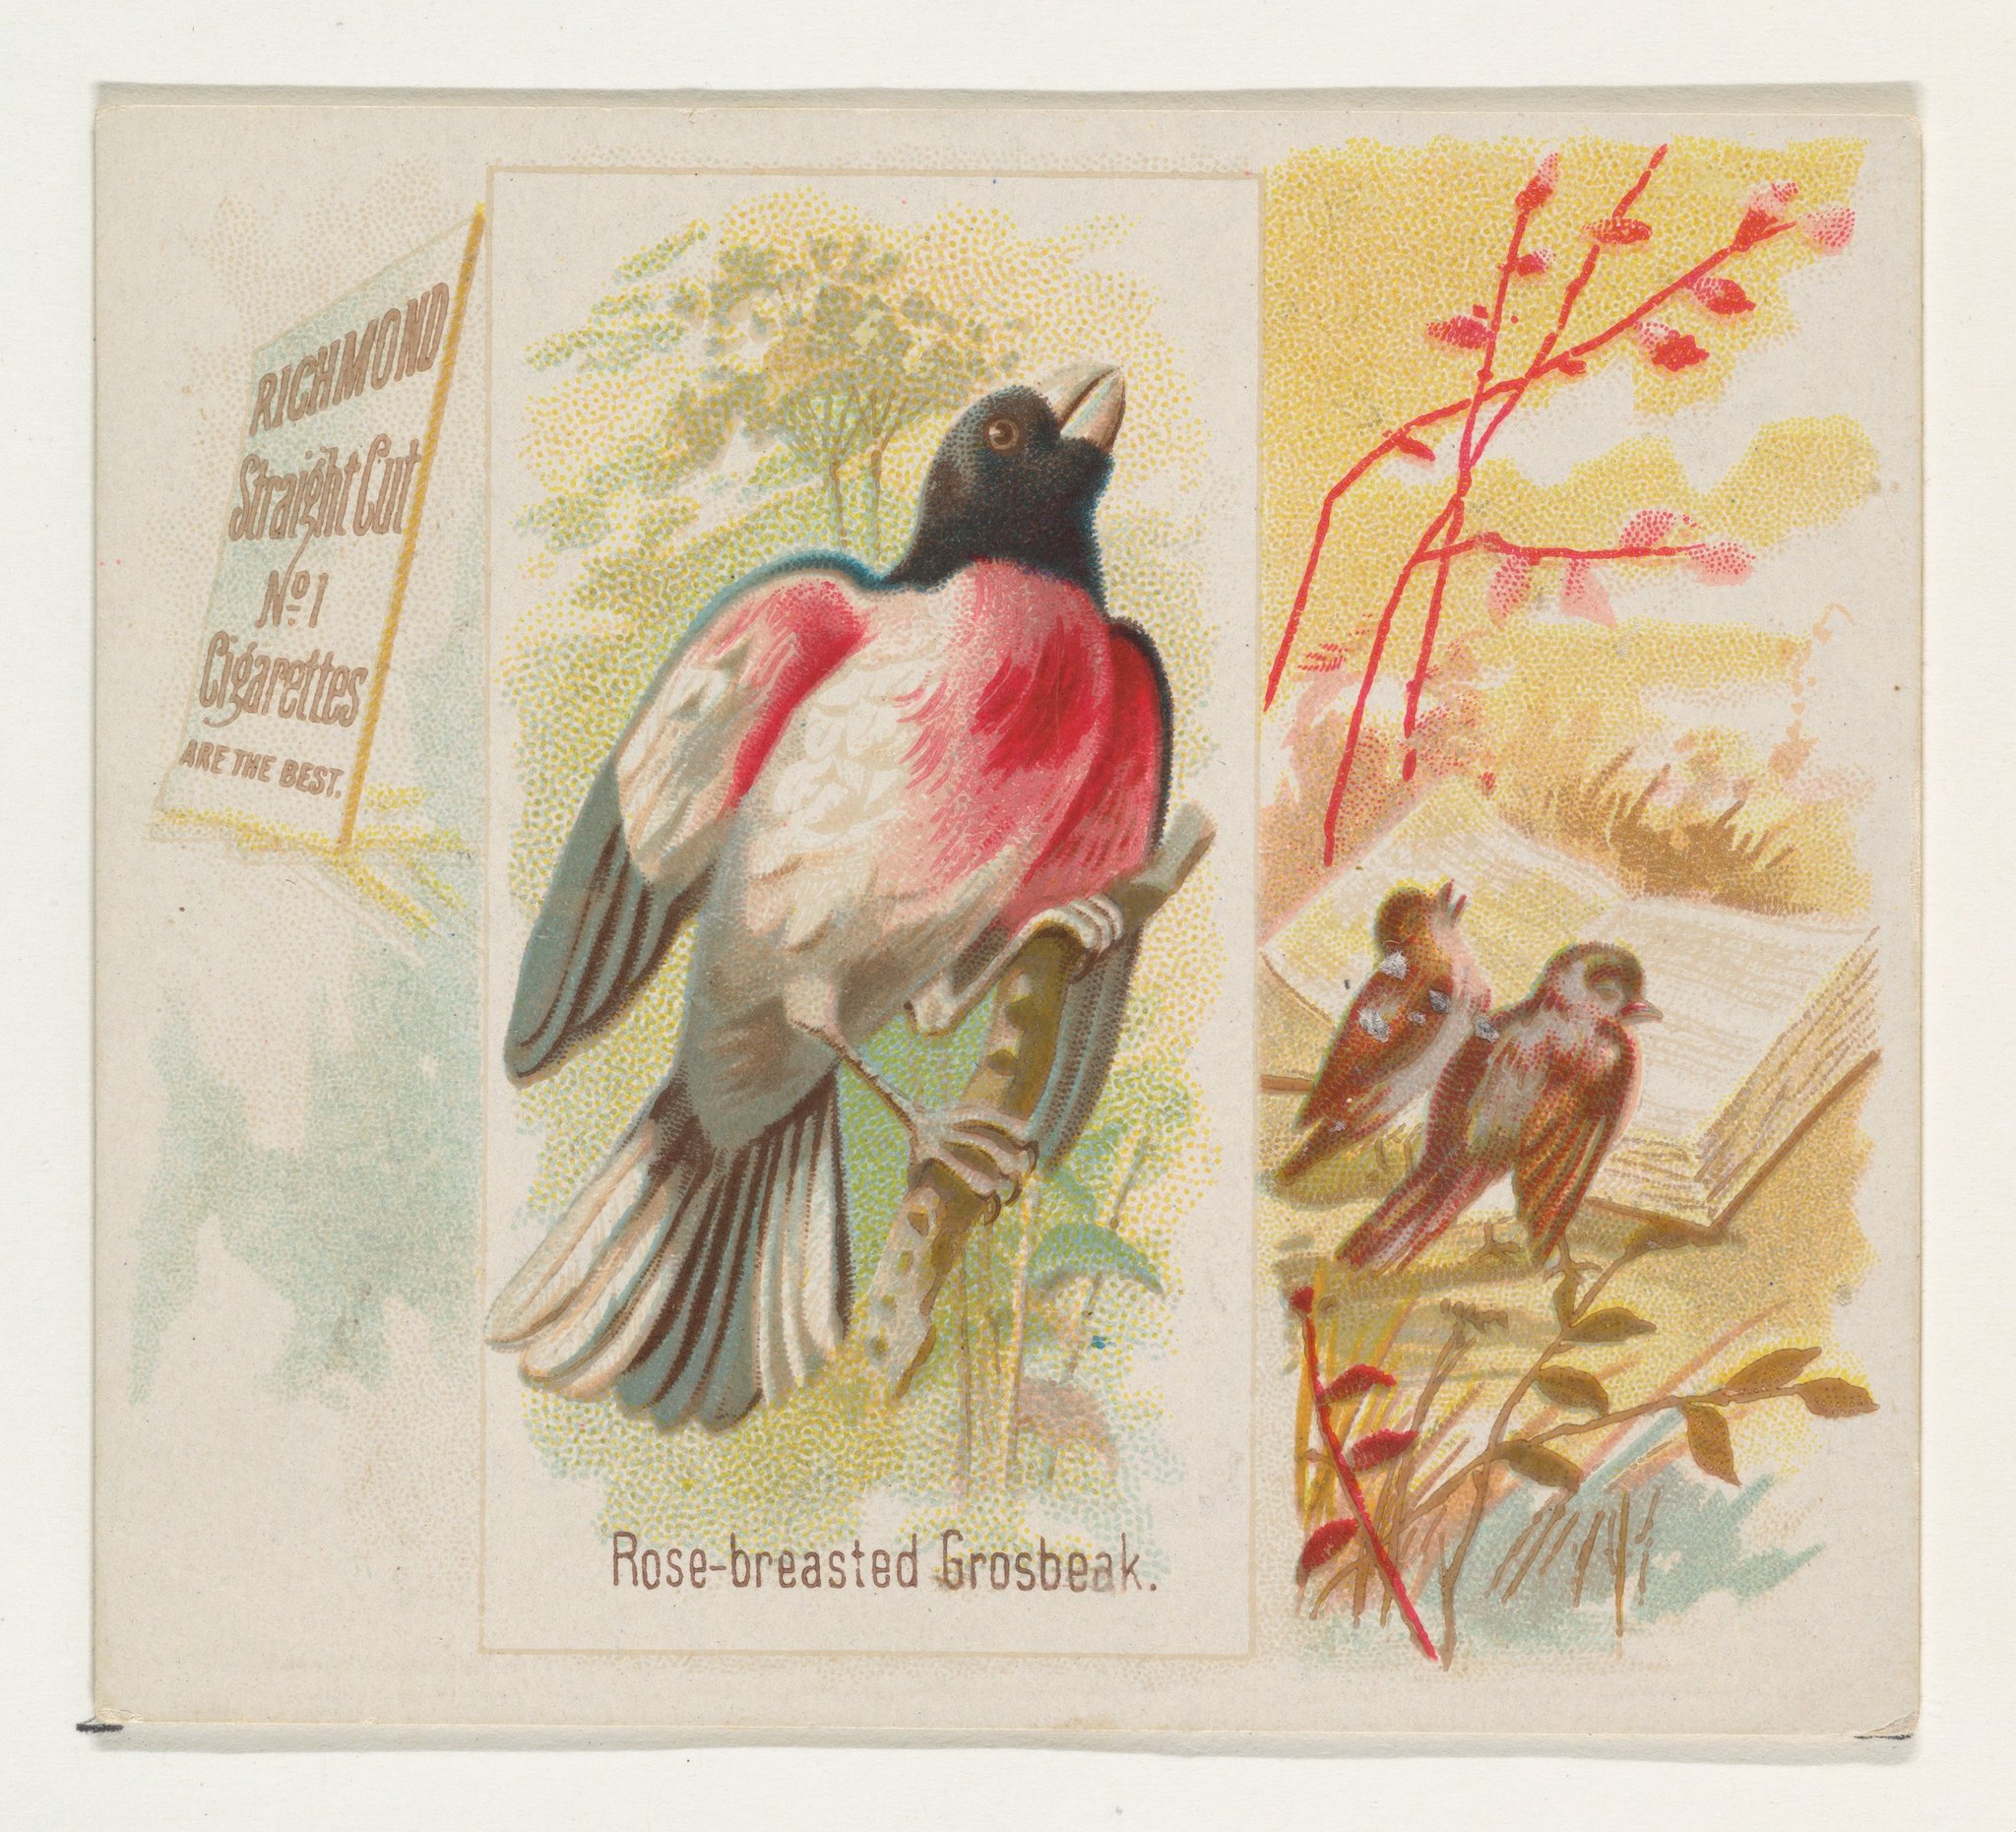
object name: print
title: Rose-breasted Grosbeak, from the Song Birds of the World series (N42) for Allen & Ginter Cigarettes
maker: allen & ginter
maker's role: publisher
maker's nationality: american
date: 1890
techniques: color lithograph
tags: birds